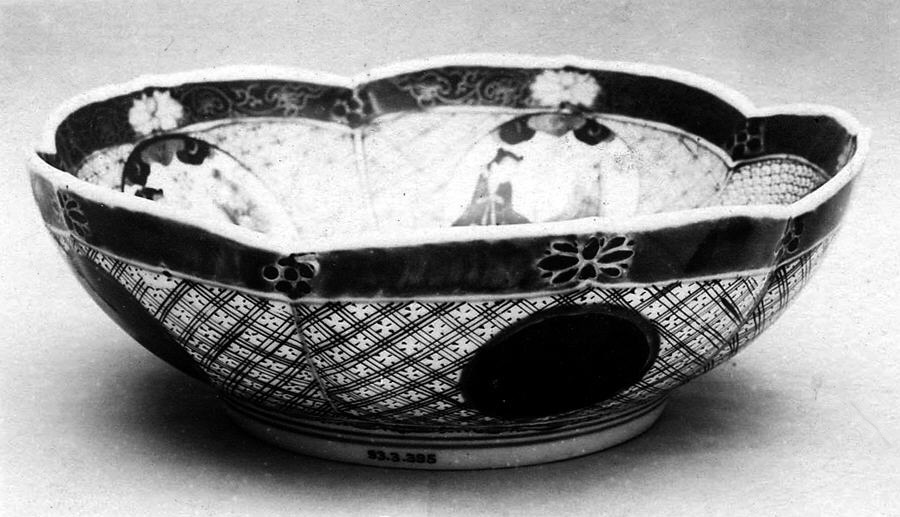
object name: bowl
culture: japanese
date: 1750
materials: enamel, glaze, porcelain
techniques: polychrome